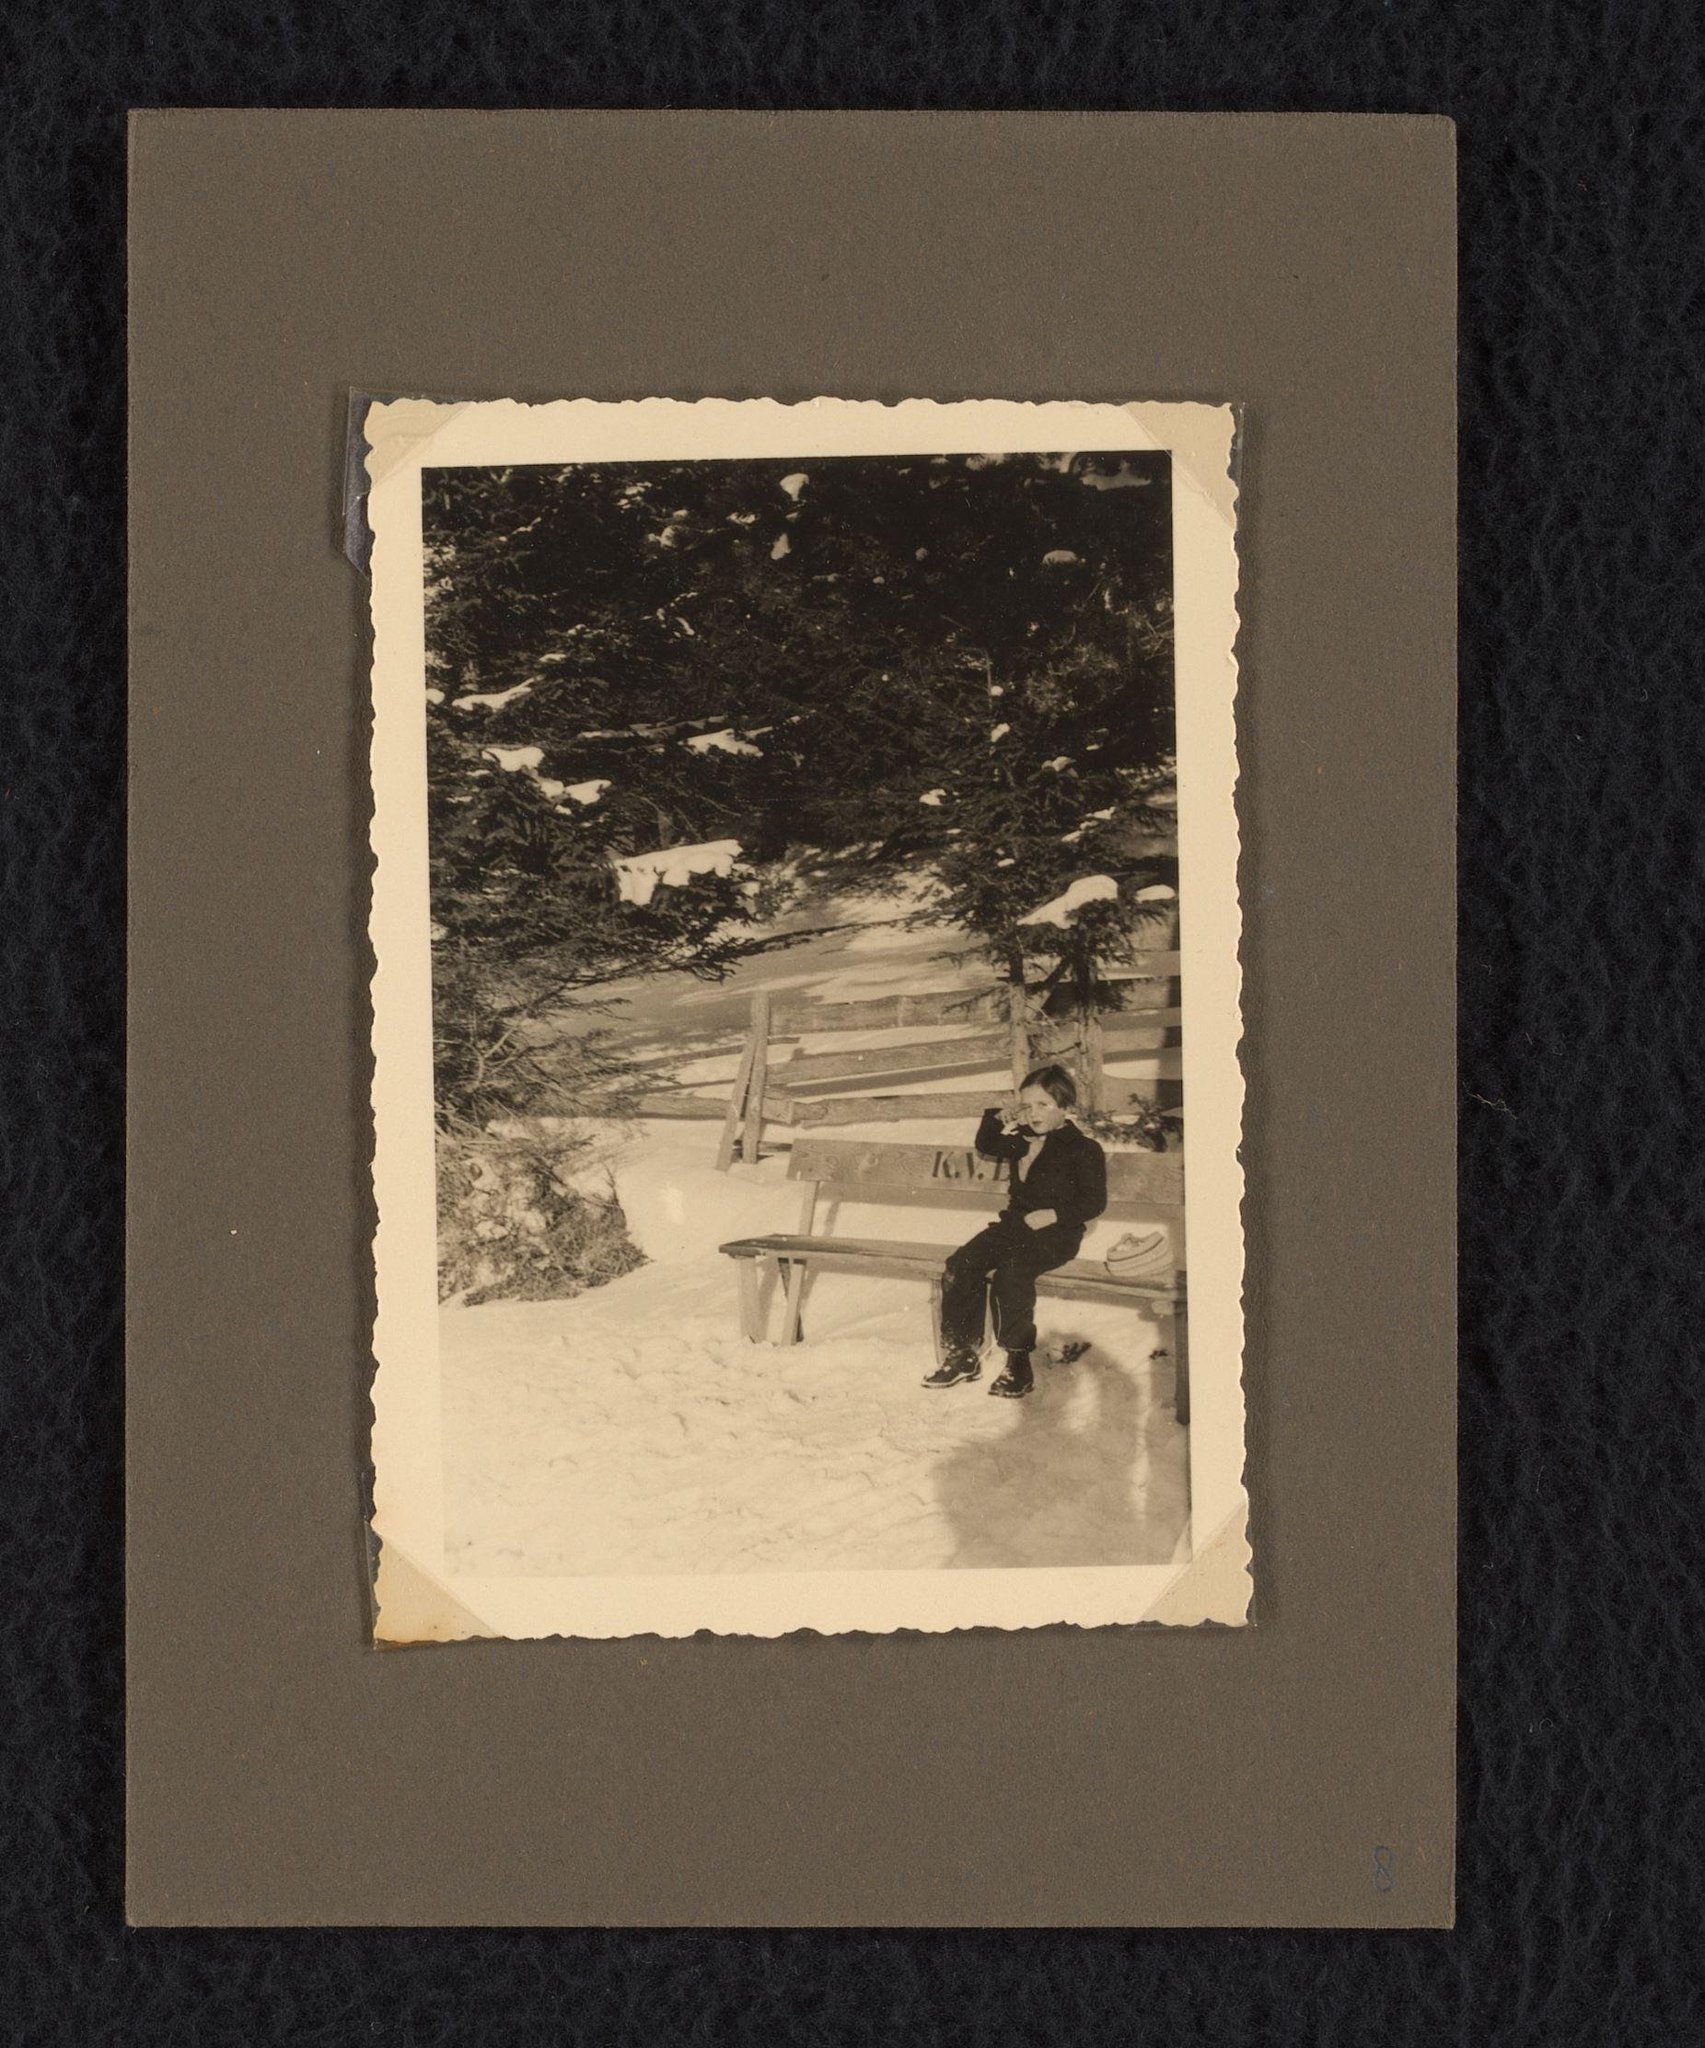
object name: photograph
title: Isabel op een bankje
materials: cardboard, photographic support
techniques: gelatin silver print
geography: lenzerheide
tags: leiden, isabel wachenheimer-elon, the family travelling, on holiday, snow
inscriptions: date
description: Albumblad met een foto van Isabel Wachenheimer in de sneeuw op een zitbank. Onderdeel van het fotoalbum met vakantiefoto's Lenzerheide, 1934.